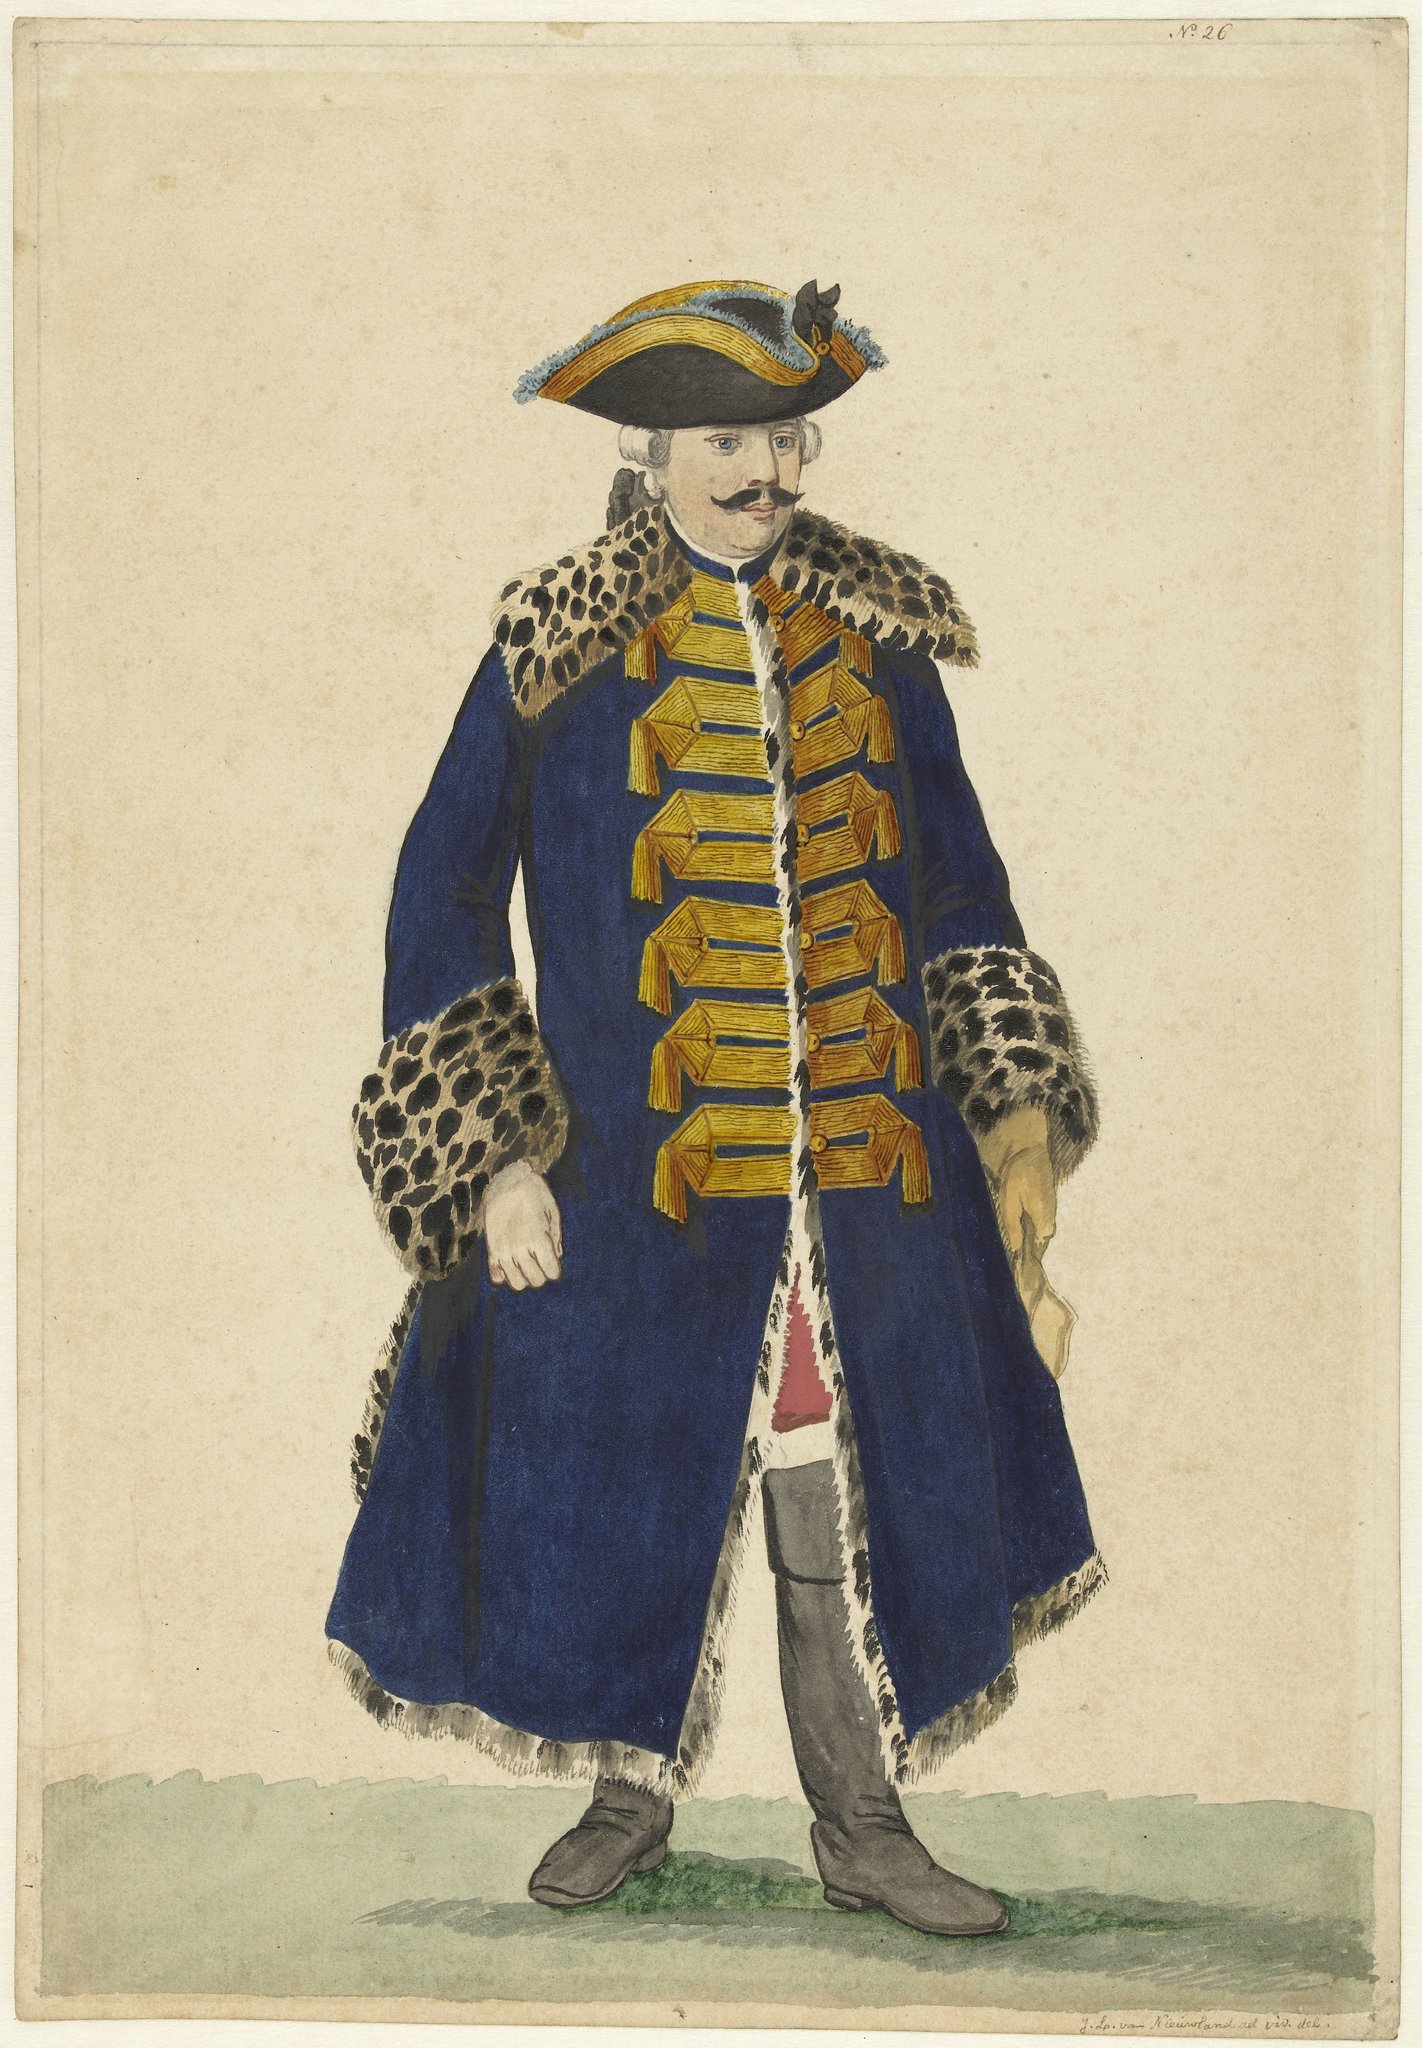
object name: drawing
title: Costumes van het hof van Willem V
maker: isaac lodewijk la fargue van nieuwland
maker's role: draughtsman, painter, print maker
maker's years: 1726-1805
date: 1766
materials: ink, paper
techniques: brush, pen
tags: the hague, william v (prince of orange)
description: Blad 13 uit serie van 24 tekeningen met leden van de hofhouding van stadhouder Willem V.